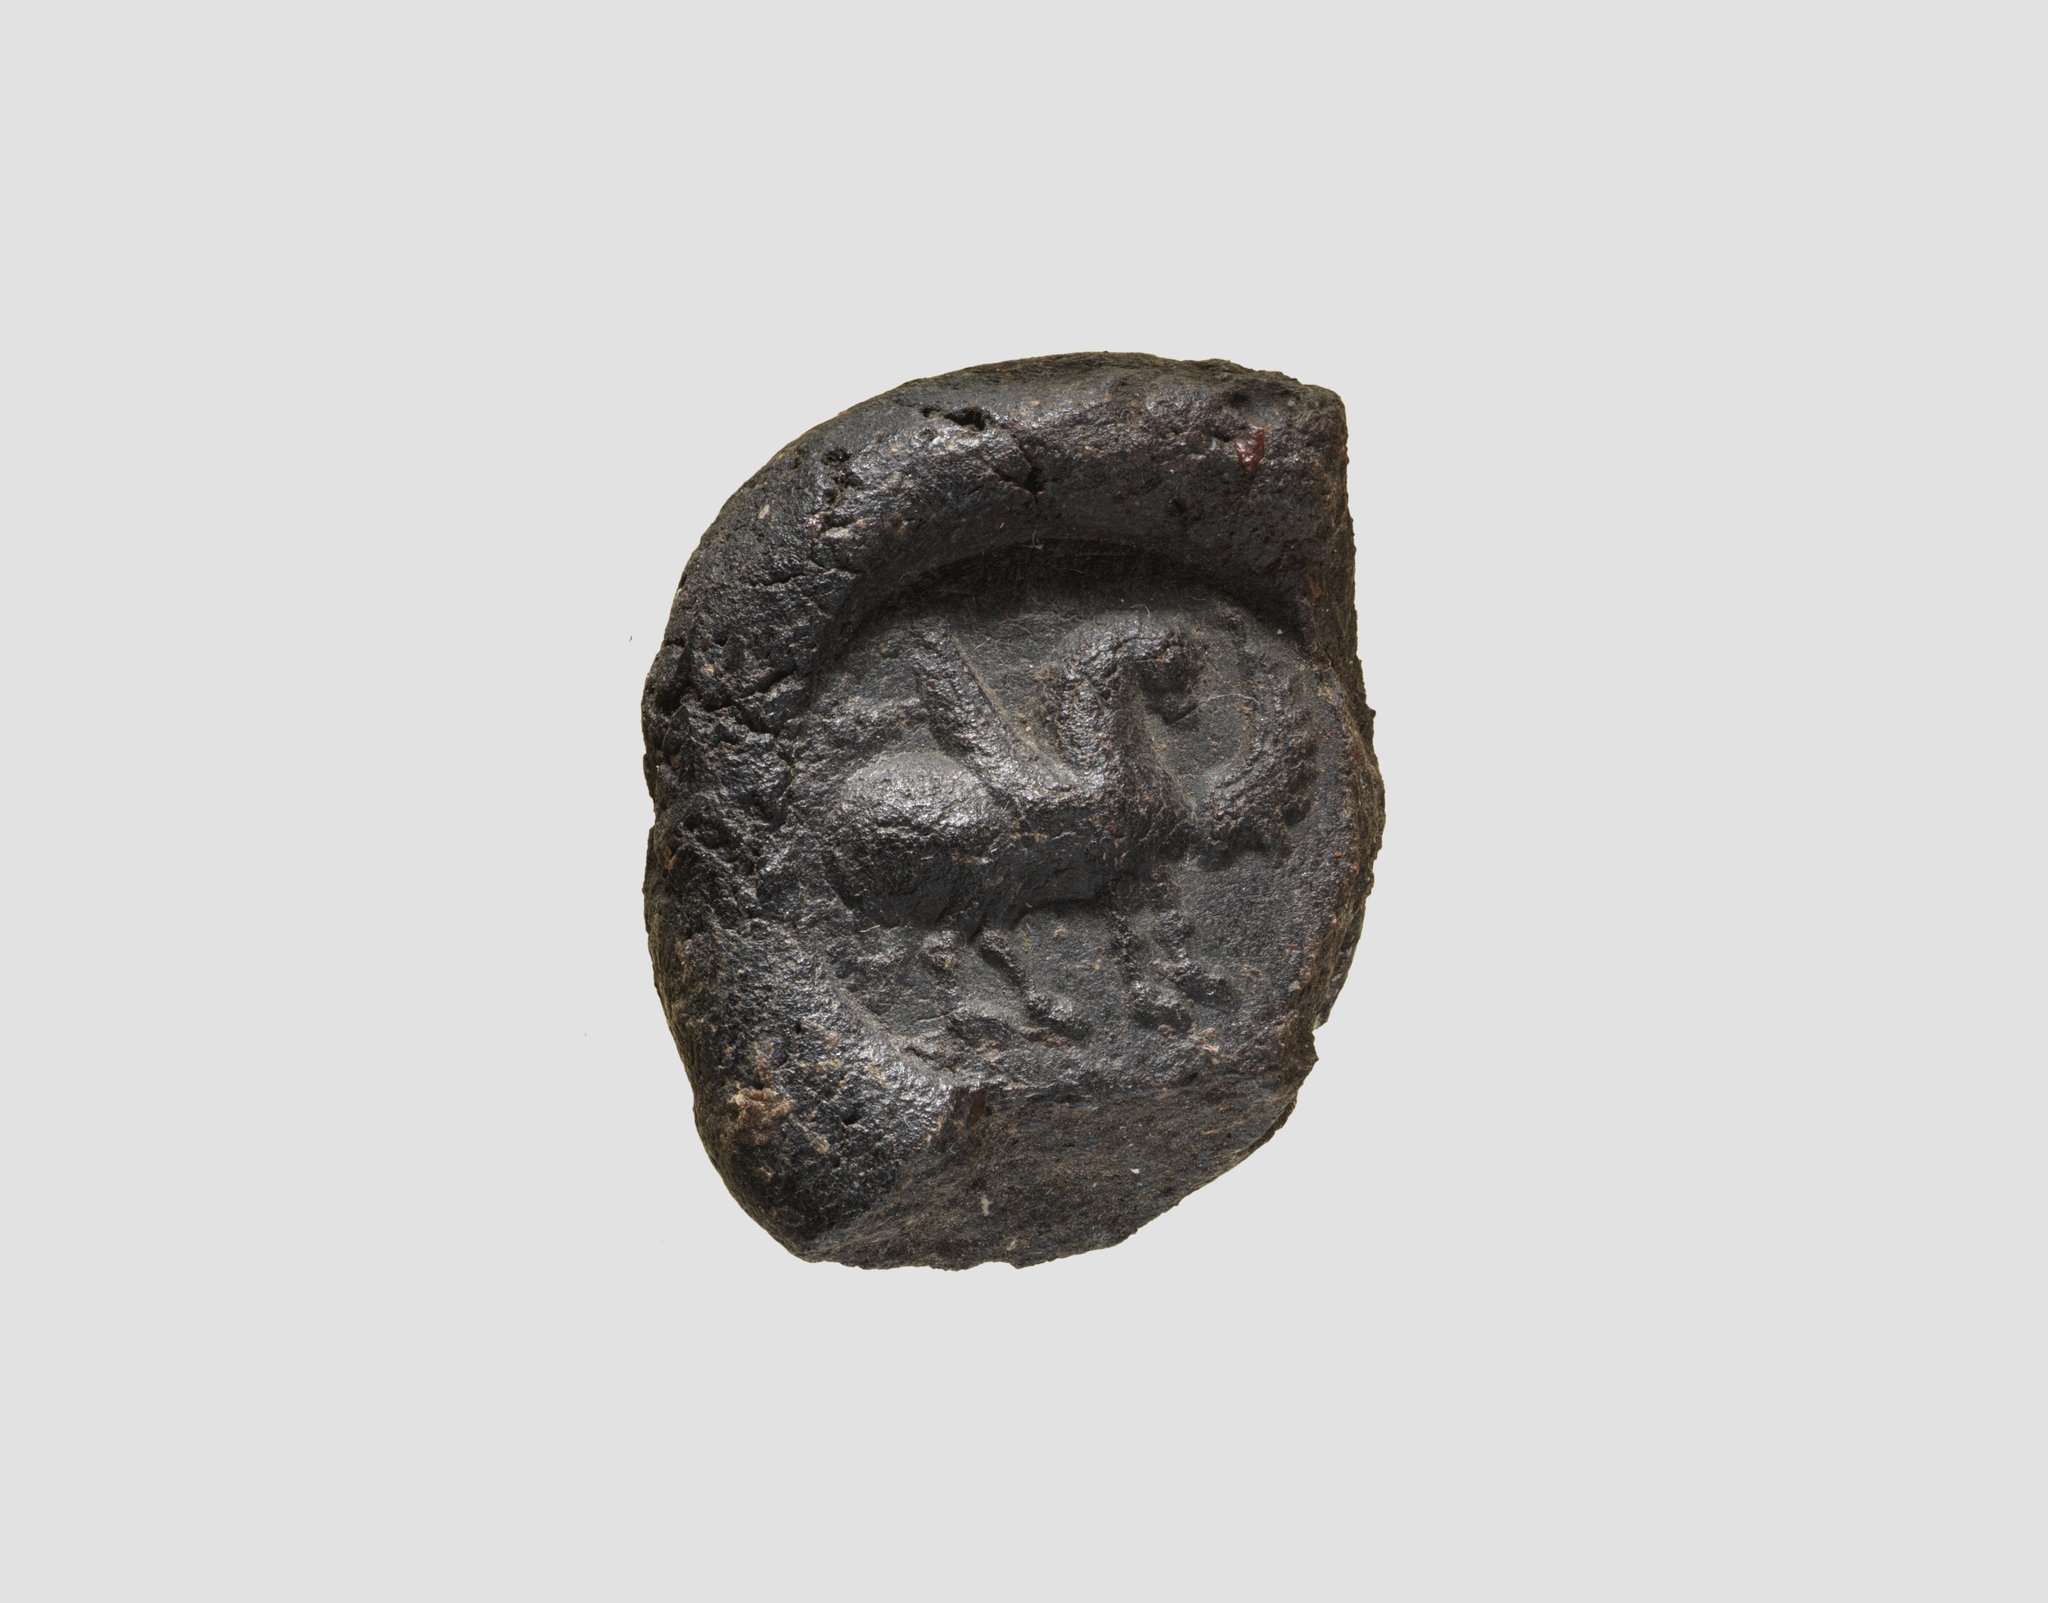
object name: sealing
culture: sasanian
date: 601-700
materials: clay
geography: iran